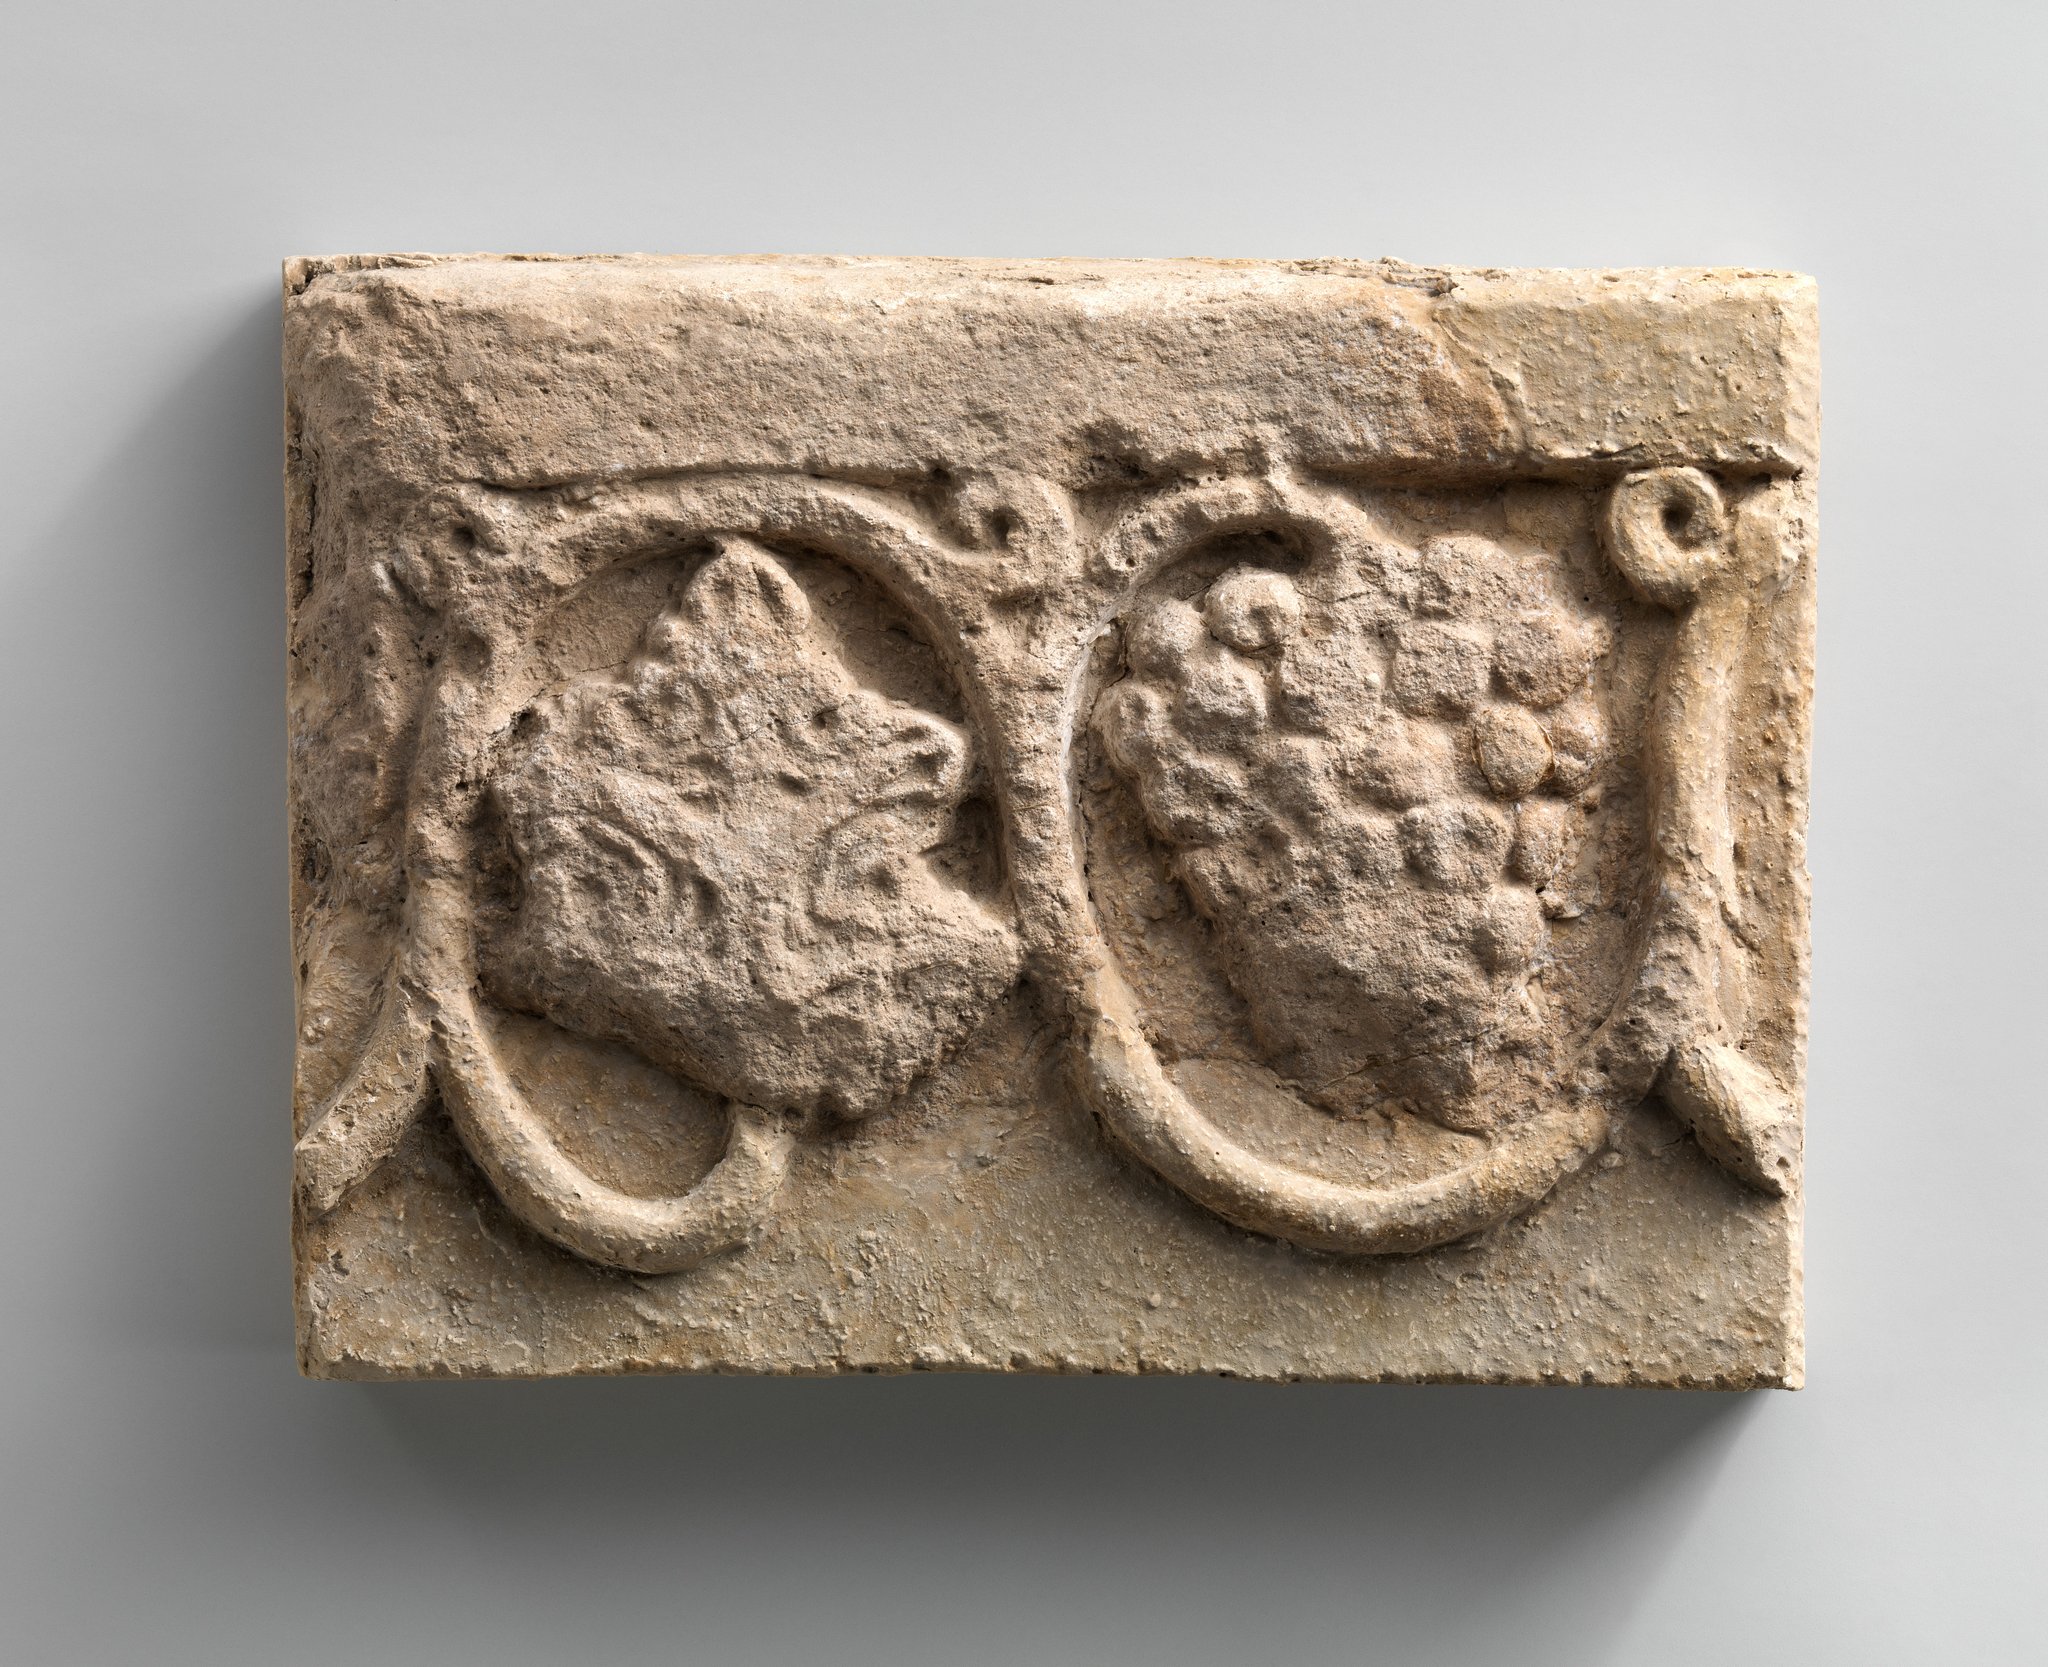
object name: relief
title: Wall decoration with a grapevine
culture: sasanian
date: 501-600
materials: plaster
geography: mesopotamia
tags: grapes